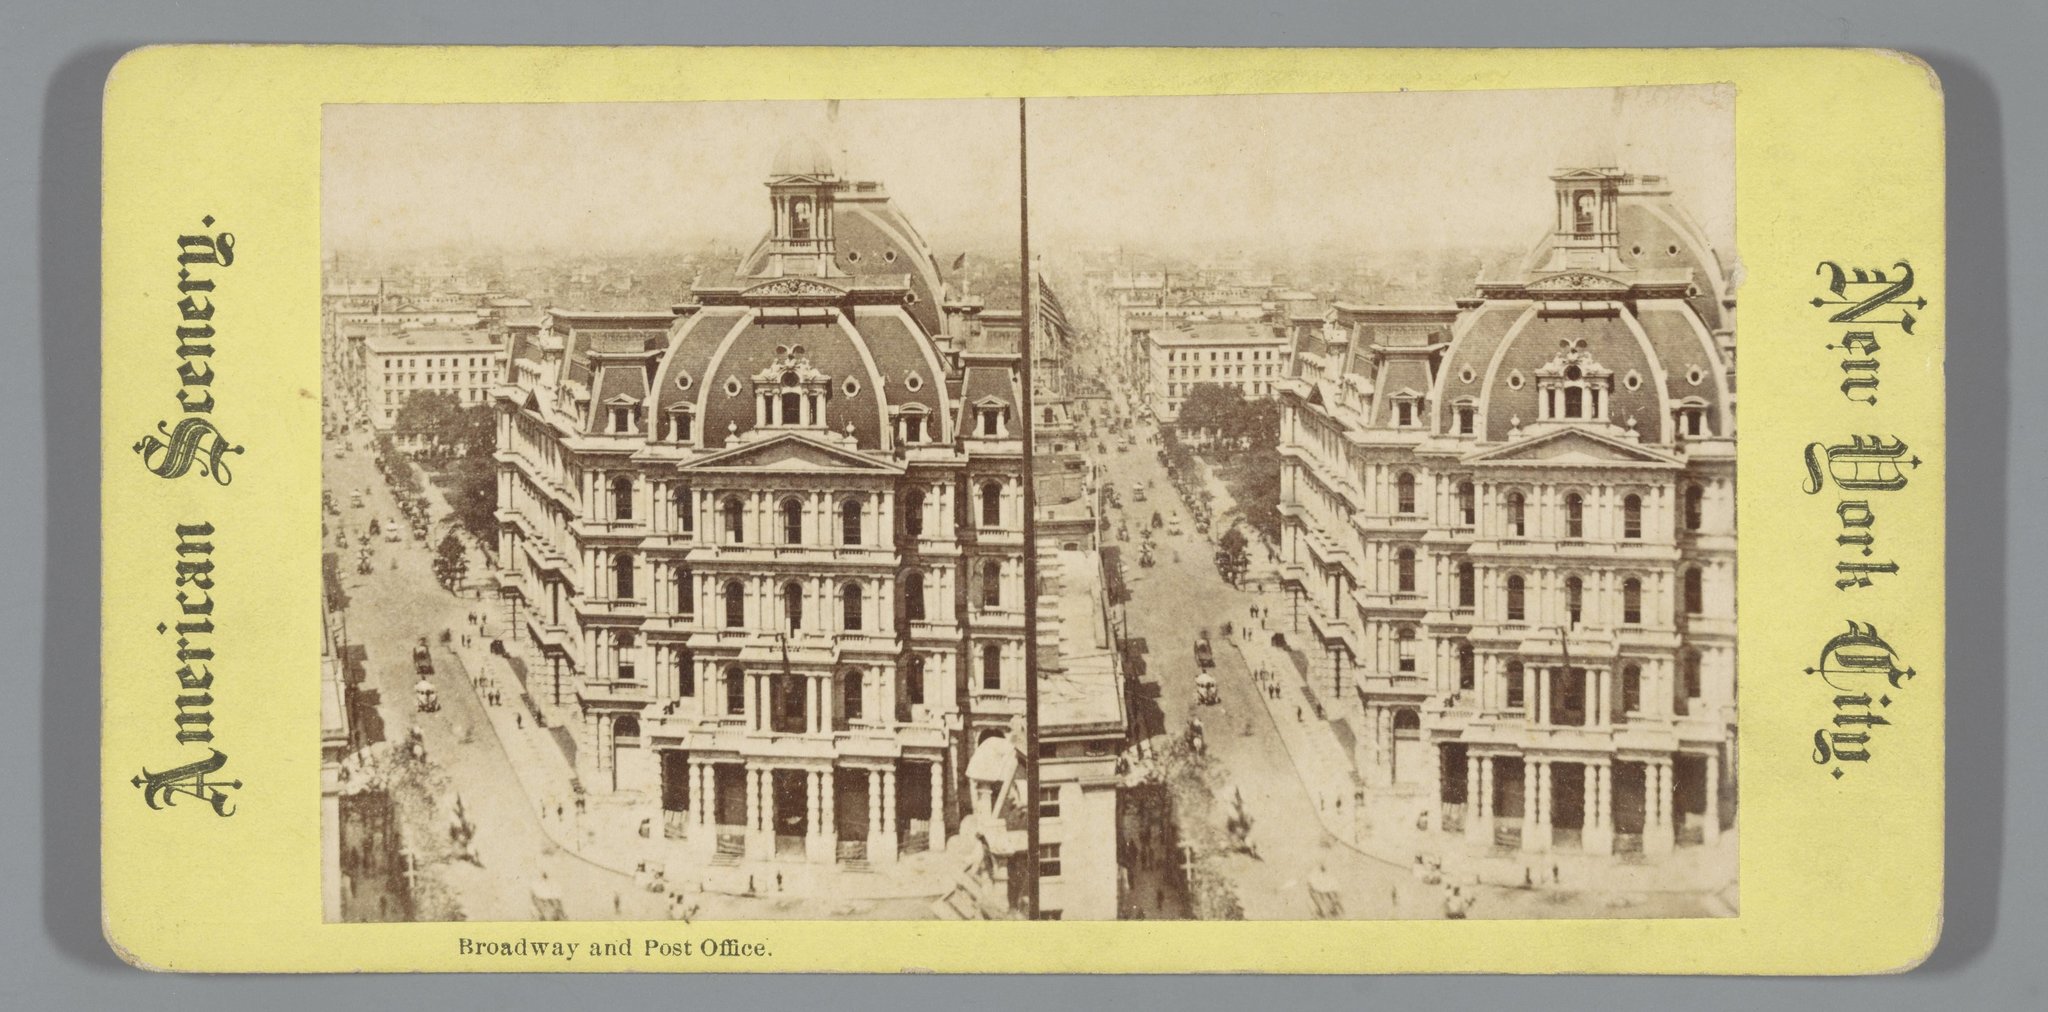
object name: stereograph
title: New York City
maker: Anonymous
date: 1868-1890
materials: cardboard, paper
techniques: albumen print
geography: new york city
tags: city-view in general; 'veduta', façade (of house or building)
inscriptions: inscription: ‘P’, title: ‘Postkantoor’